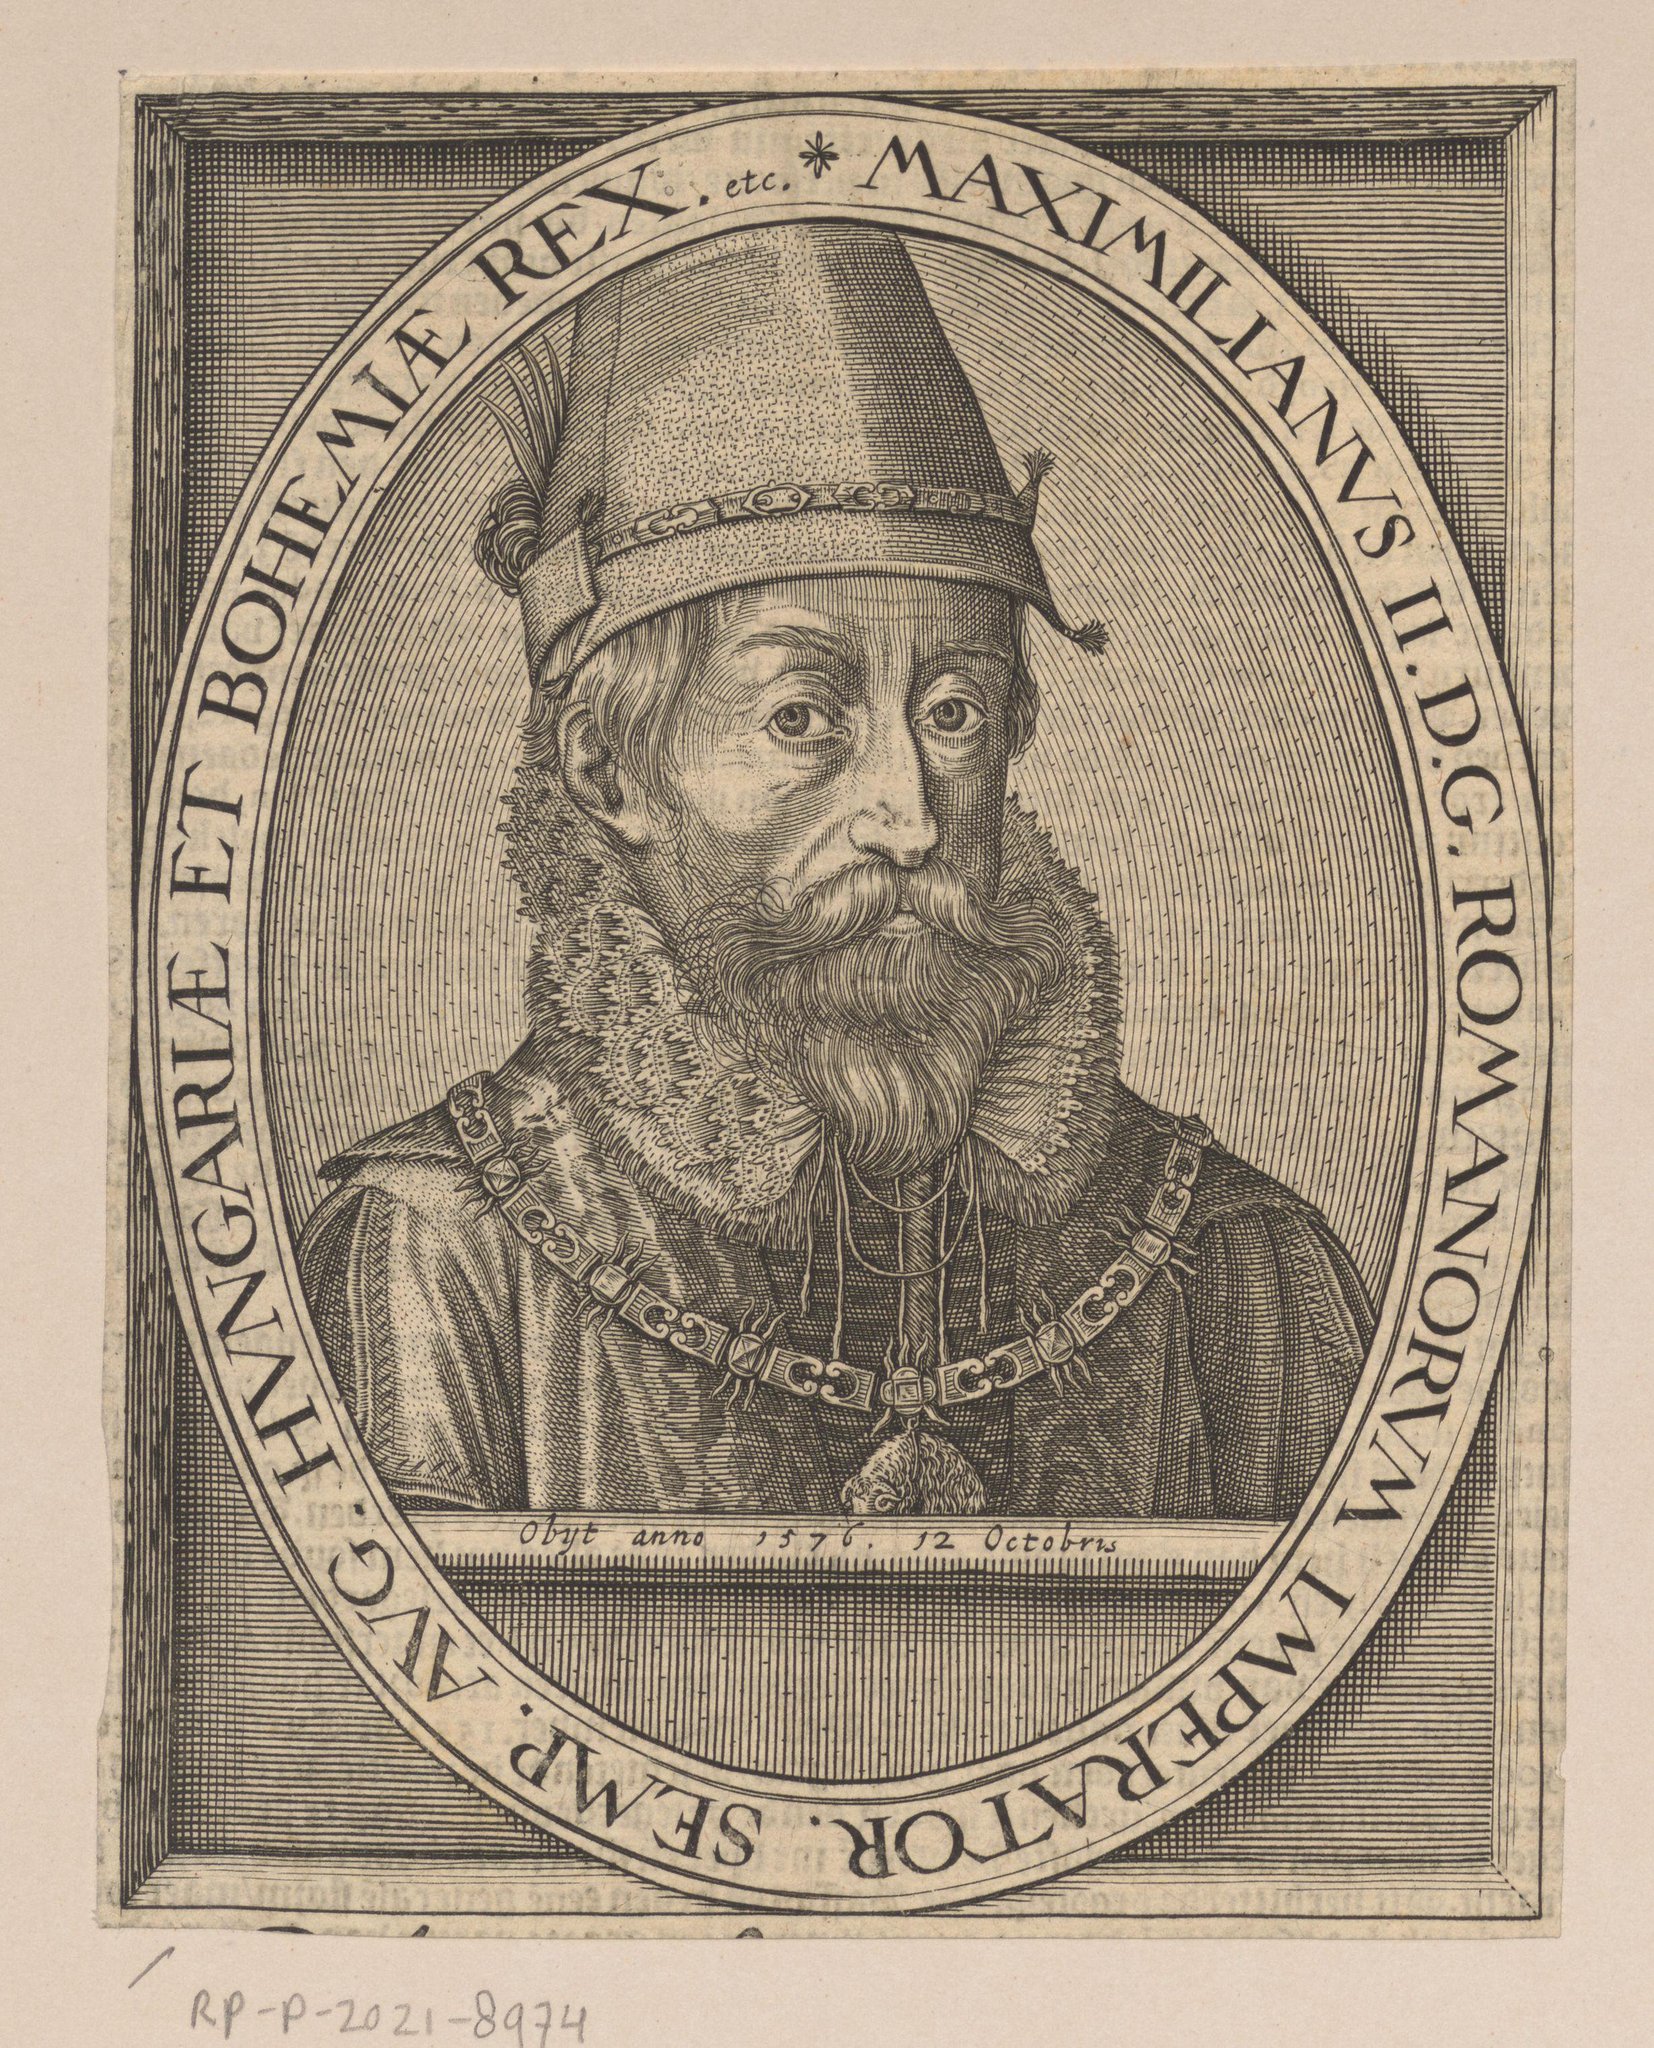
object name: print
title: Portret van keizer Maximiliaan II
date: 1615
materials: paper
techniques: engraving, letterpress printing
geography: northern netherlands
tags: vienna, maximiliaan ii (keizer van heilige roomse rijk), ornament ~ medallion, historical persons, knighthood order of the golden fleece - insignia of a knighthood order, e.g.: badge, chain (with name of order)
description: Adres van Nicolaes de Clerck bij dit exemplaar afgesneden. Prent uit: Tooneel der keyseren ende coningen van Christenryck sedert den onderganck van het Griecks keyserdom (...). Arnhem: Jan Jansz., 1615. Prent ook gebruikt in Van Meterens 'Historie der Nederlandscher ende haerder Na-buren Oorlogen', 1614.